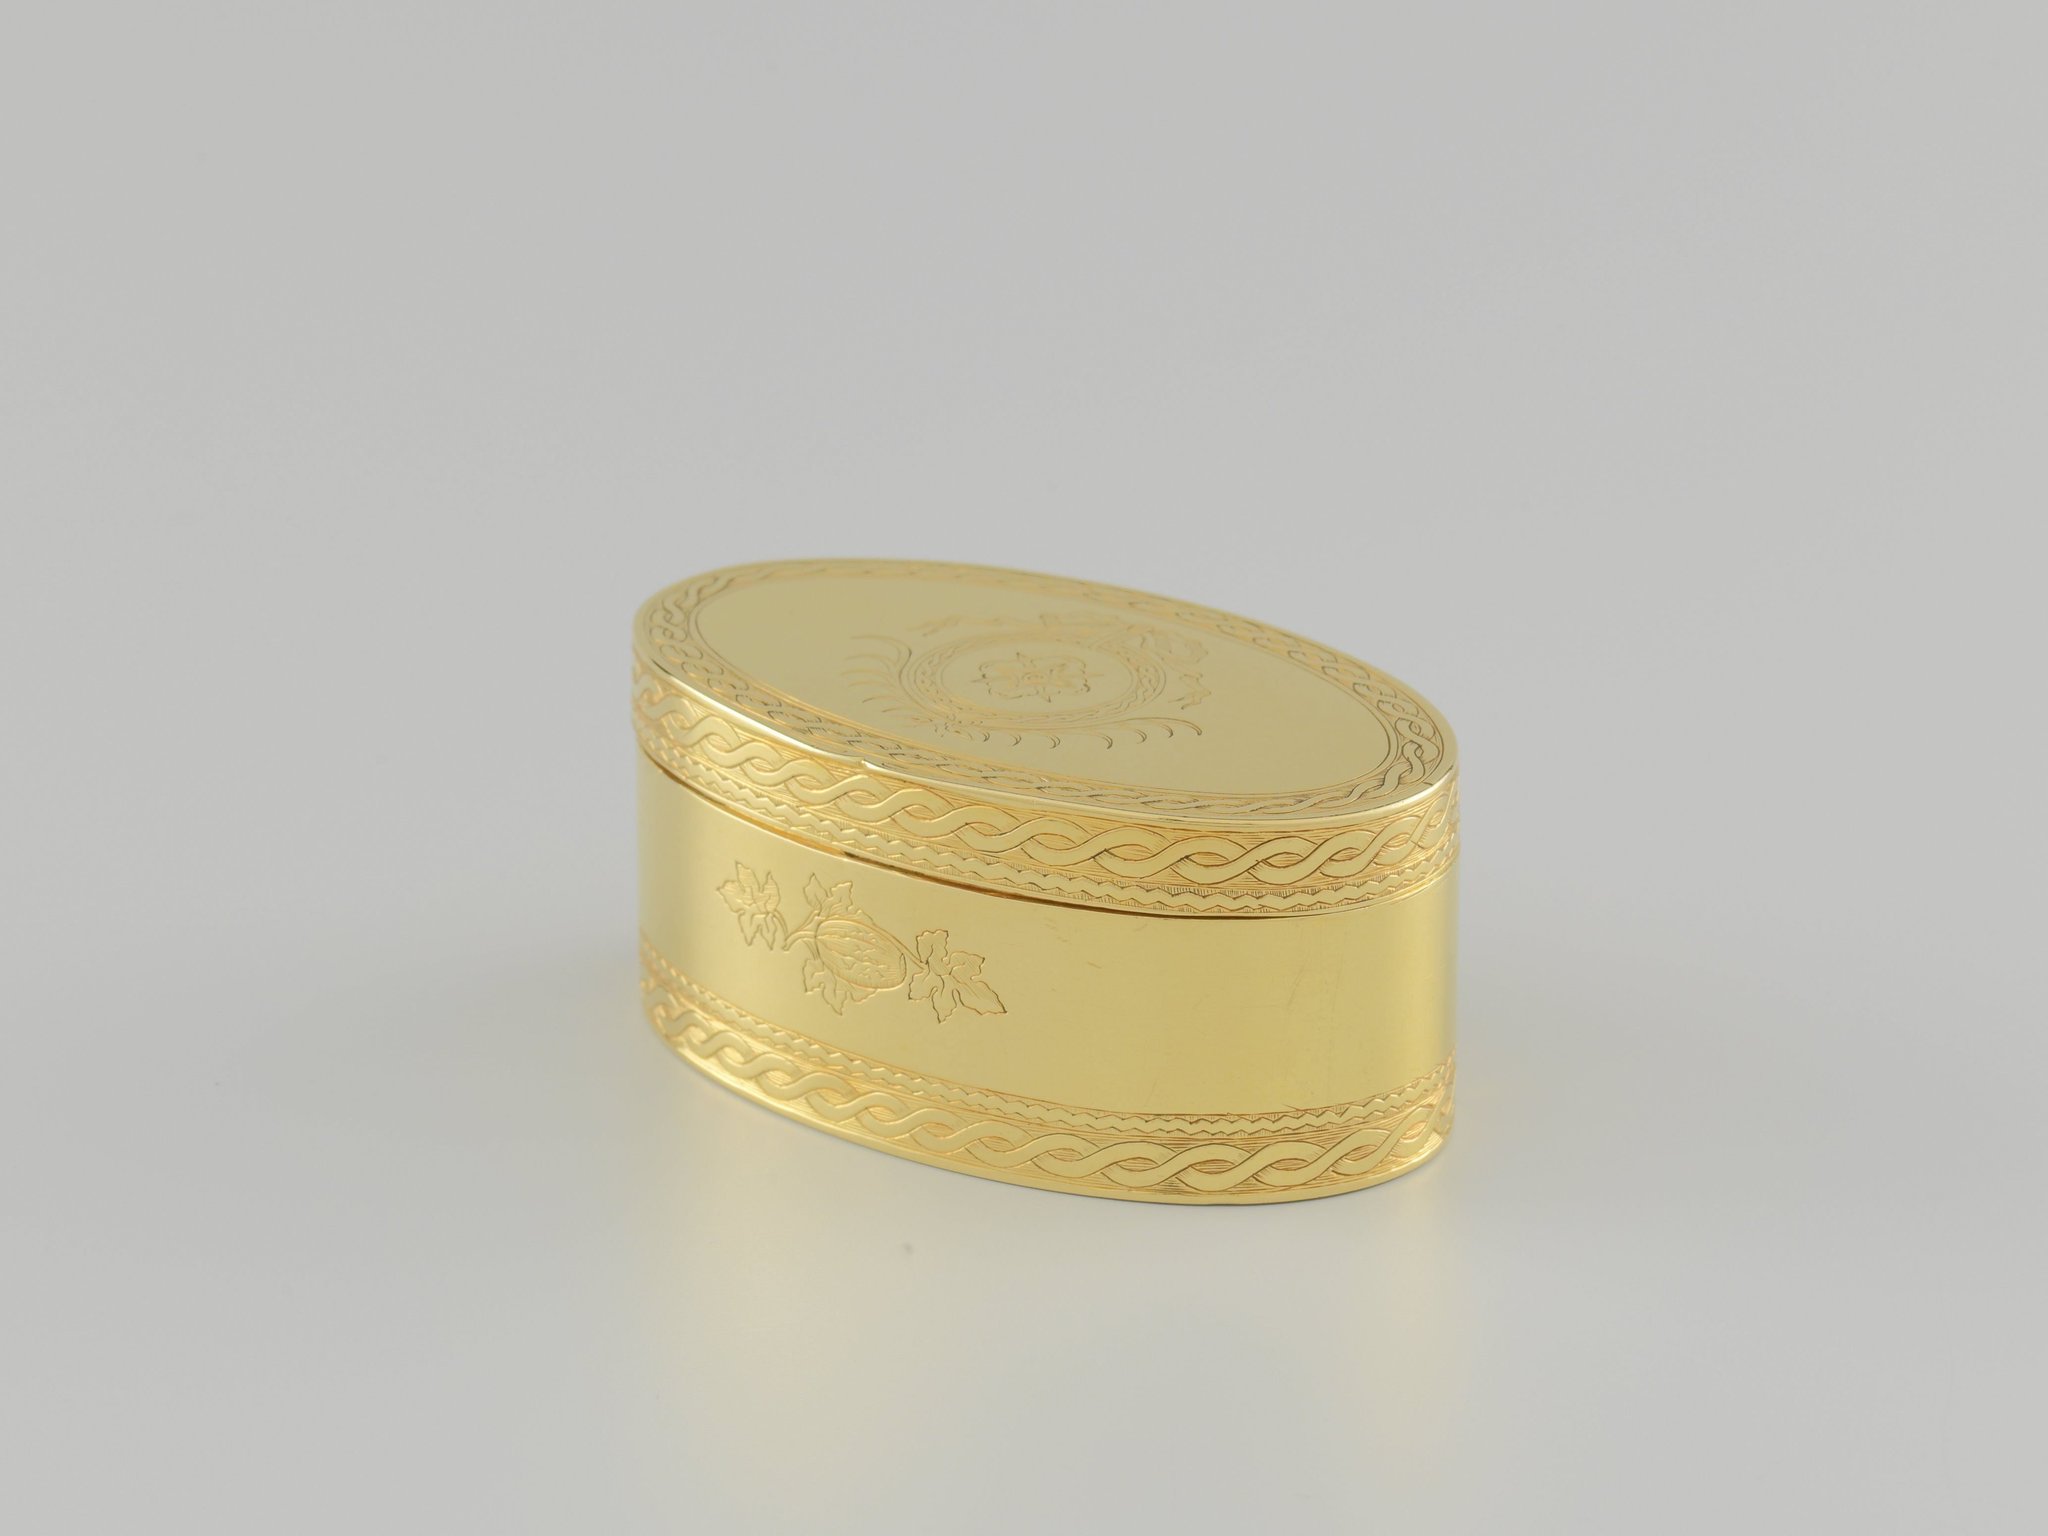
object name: snuffbox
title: Snuifdoos van goud, ovaal met rechte wanden. Op voor- en achterzijde een gegraveerde pompoentak met vrucht en vier bladeren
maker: laurens potmans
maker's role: goud- en zilversmid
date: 1784-1786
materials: gold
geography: middelburg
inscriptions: mark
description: Snuffbox. Gold. With a portrait of Nicolaas Pancras. Amsterdam, 1743, by Jean Soumain. Snuffbox. Gold. Middelburg, 1784 - 1786, by L. Potmans.